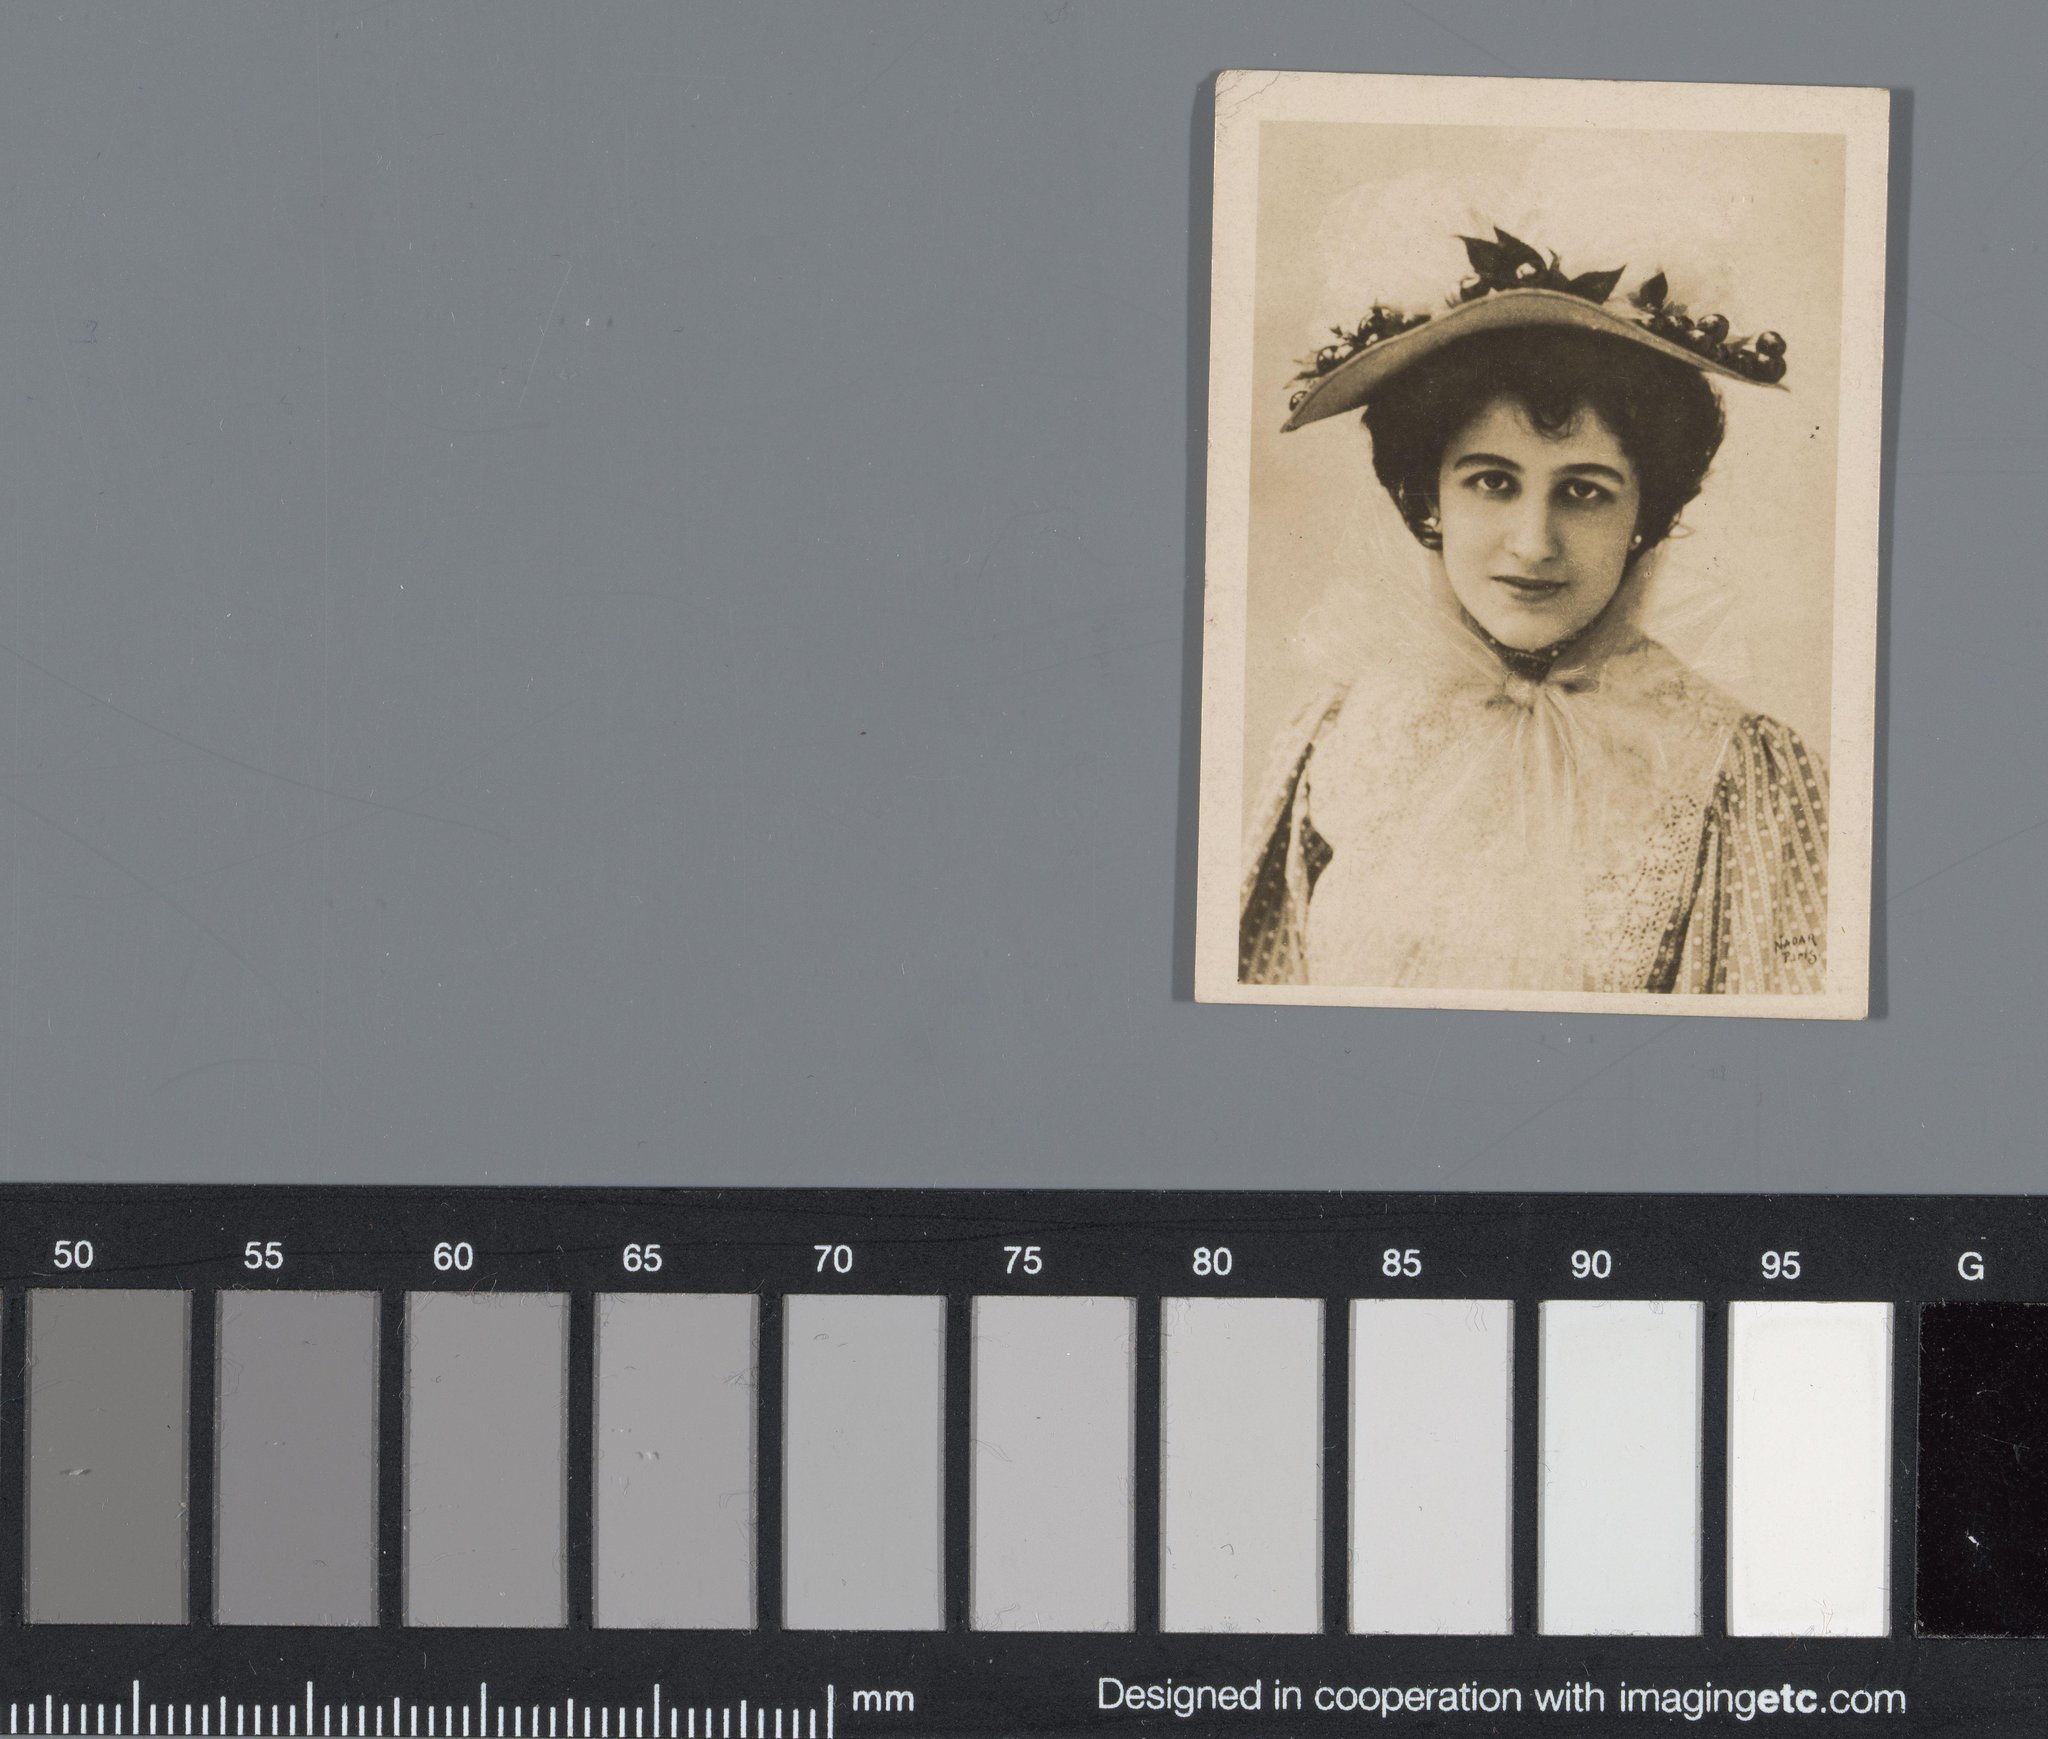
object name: photograph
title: Portret van een onbekende vrouw met hoed, reclame voor Mafiadis et Cie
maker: félix nadar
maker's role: ballonvaarder, fotograaf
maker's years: 1820-1910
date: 1890-1910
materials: cardboard, photographic support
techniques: gelatin silver print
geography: paris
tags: historical persons - bb - woman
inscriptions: inscription: ‘Cigarettes/ Mafiadis et Cie./ à Constantinople.’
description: Dergelijke foto's stonden bekend als 'zwartjes'. Men verkreeg ze bij aanschaf van bepaalde merken thee, cacao, sigaretten, beschuit, etc. om te verzamelen. Er waren speciaal voor de 'zwartjes' vervaardigde verzamelalbums in omloop.